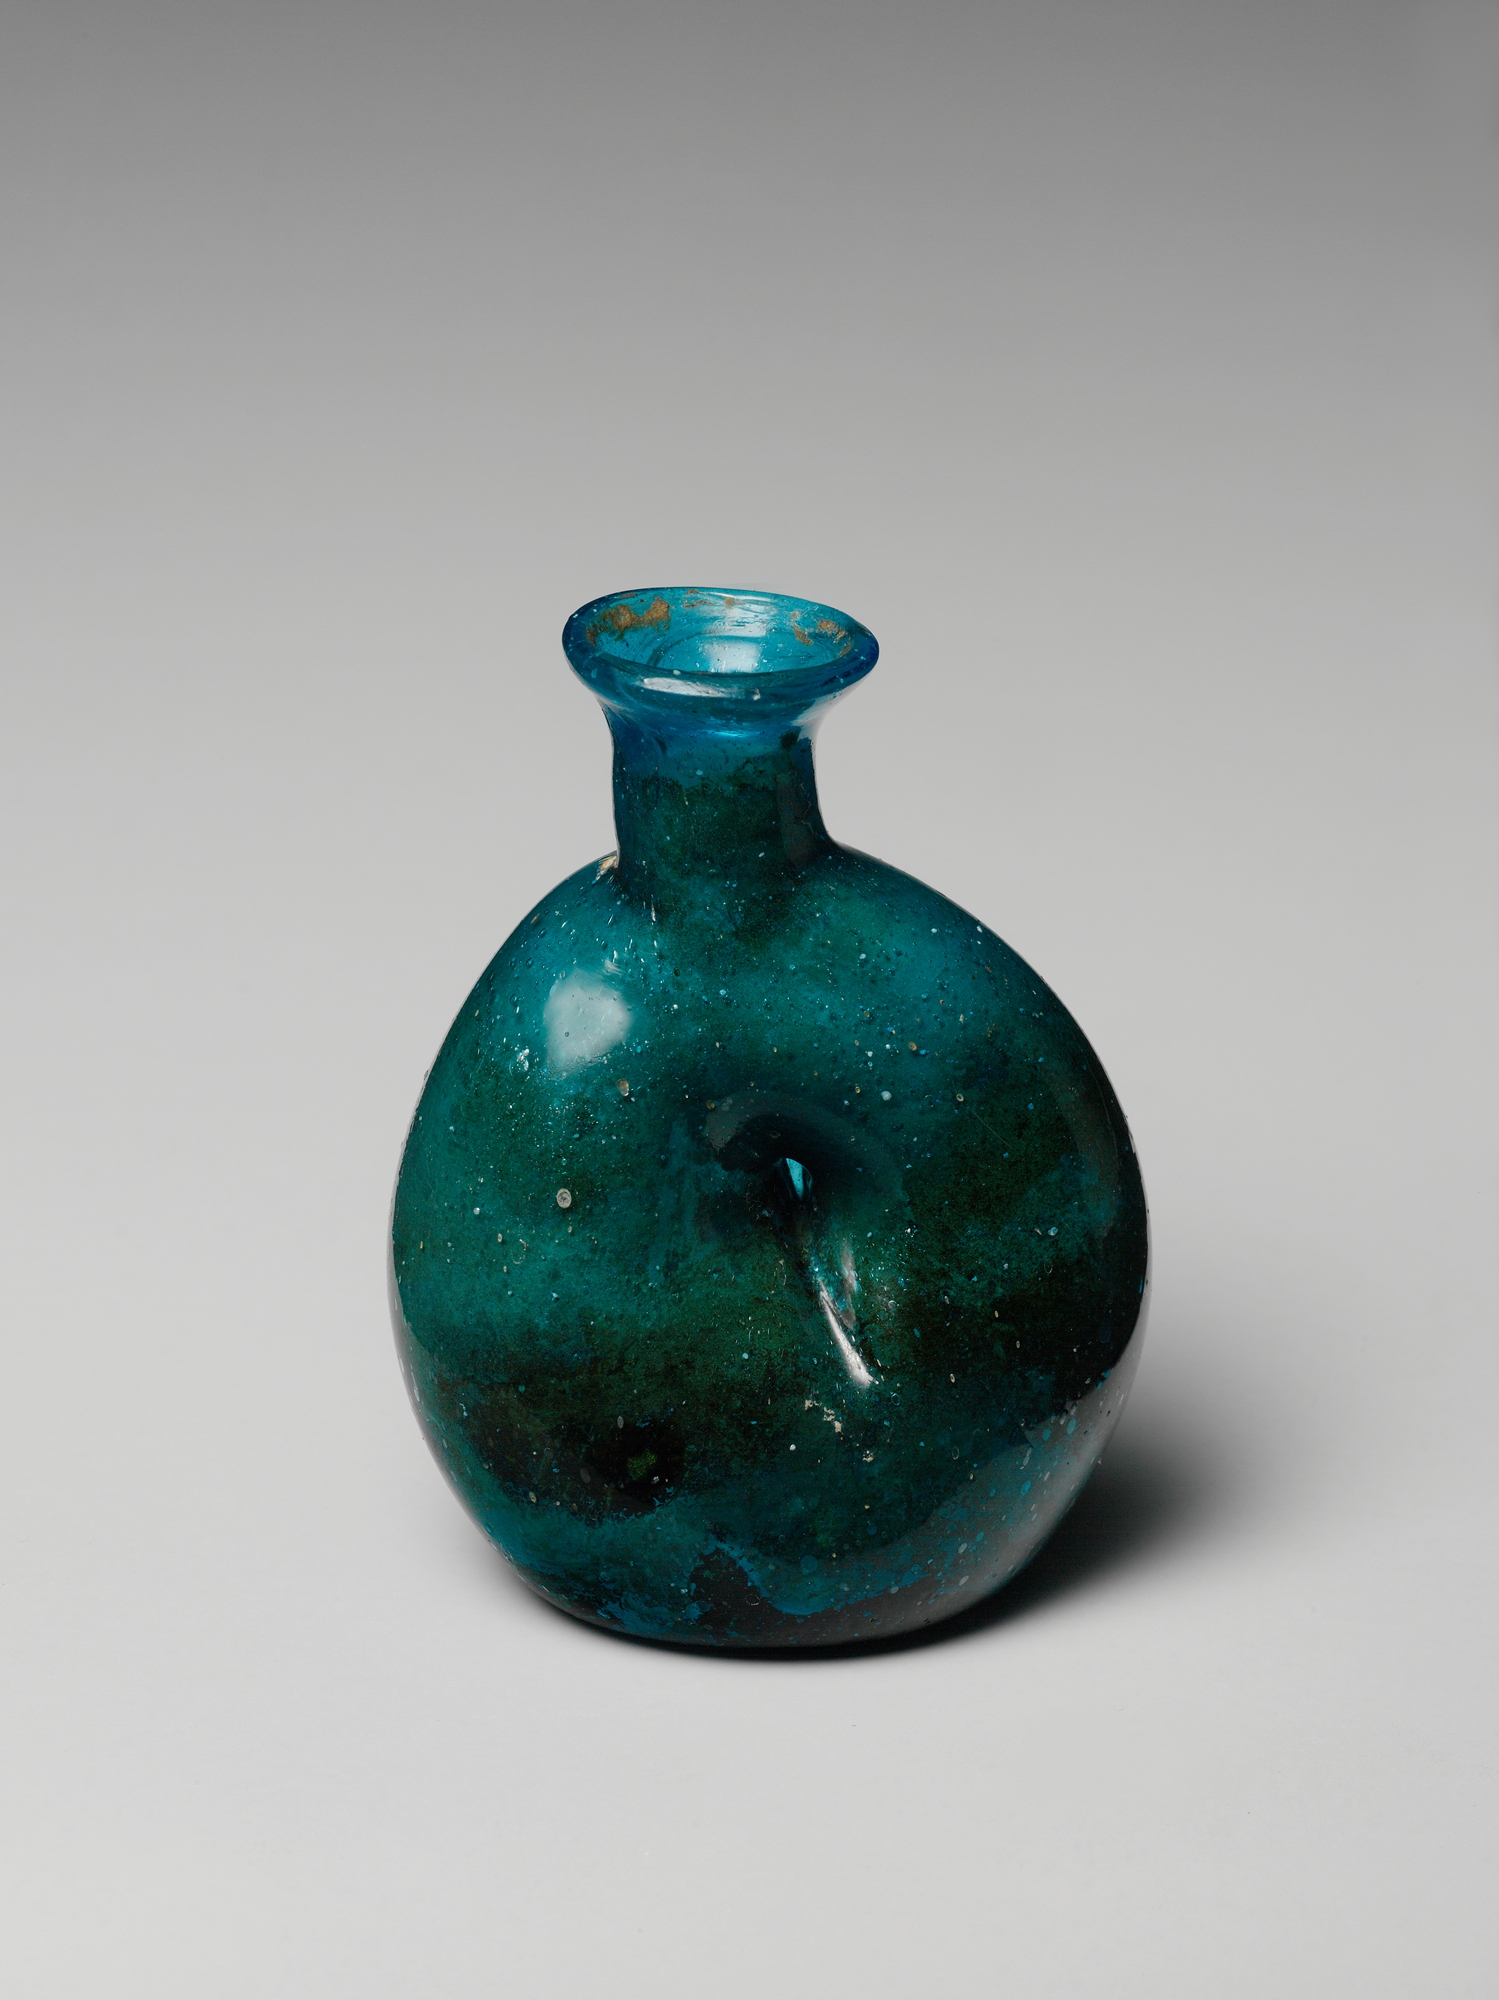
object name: flask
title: Blue Flask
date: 1701-1900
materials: glass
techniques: glassblowing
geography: iran